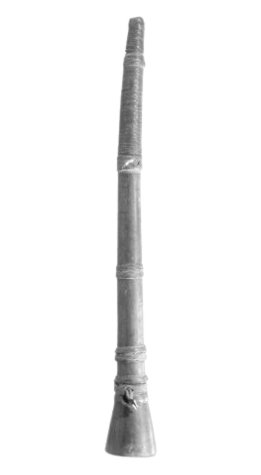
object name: horn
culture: african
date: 1867-1900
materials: leather, wood